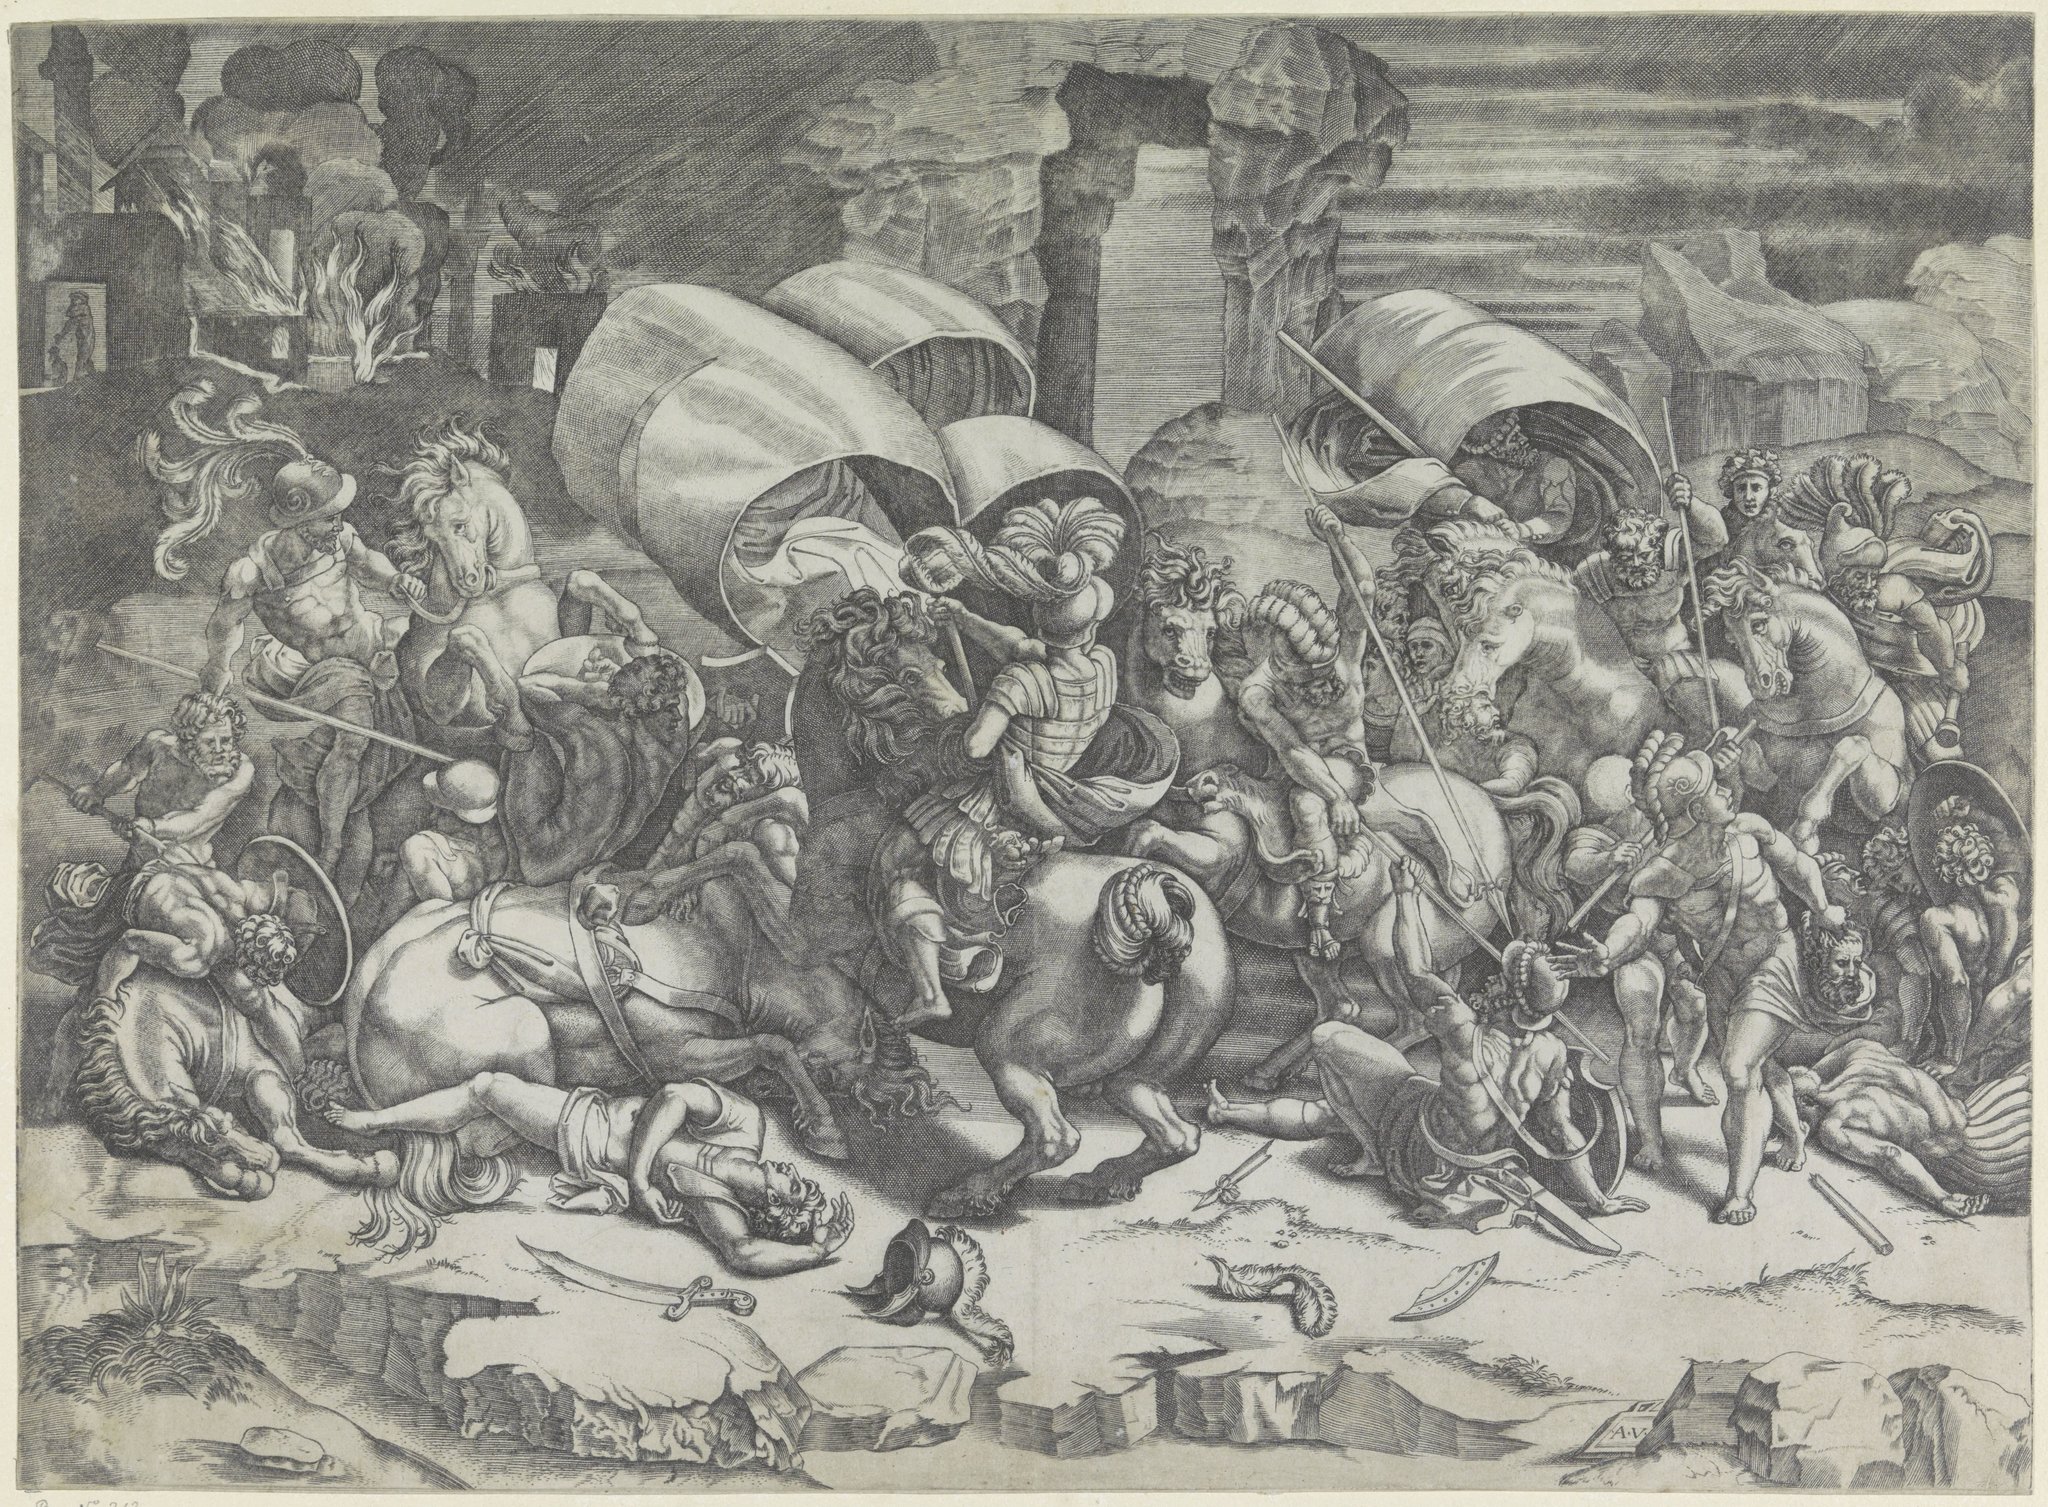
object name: print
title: Veldslag tussen Romeinen en Carthagers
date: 1500-1536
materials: paper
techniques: engraving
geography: italy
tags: battle, hacking and thrusting weapons: sword, (story of) p. cornelius scipio africanus minor (p. cornelius scipio aemilianus), setting on fire (of conquered city), the soldier; the soldier's life, fighting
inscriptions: collector's mark: Lugt 2228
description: Bartsch beschrijft deze prent als spiegelbeeldige kopie door Agostino Veneziano naar een prent mogelijk door Marco Dente (Bartsch 211). Volgens Oberhuber is het echter andersom en is de spiegelbeeldige versie een kopie naar deze prent van Agostino Veneziano. De compositie gaat mogelijk terug op een tekening van Giulio Romano.